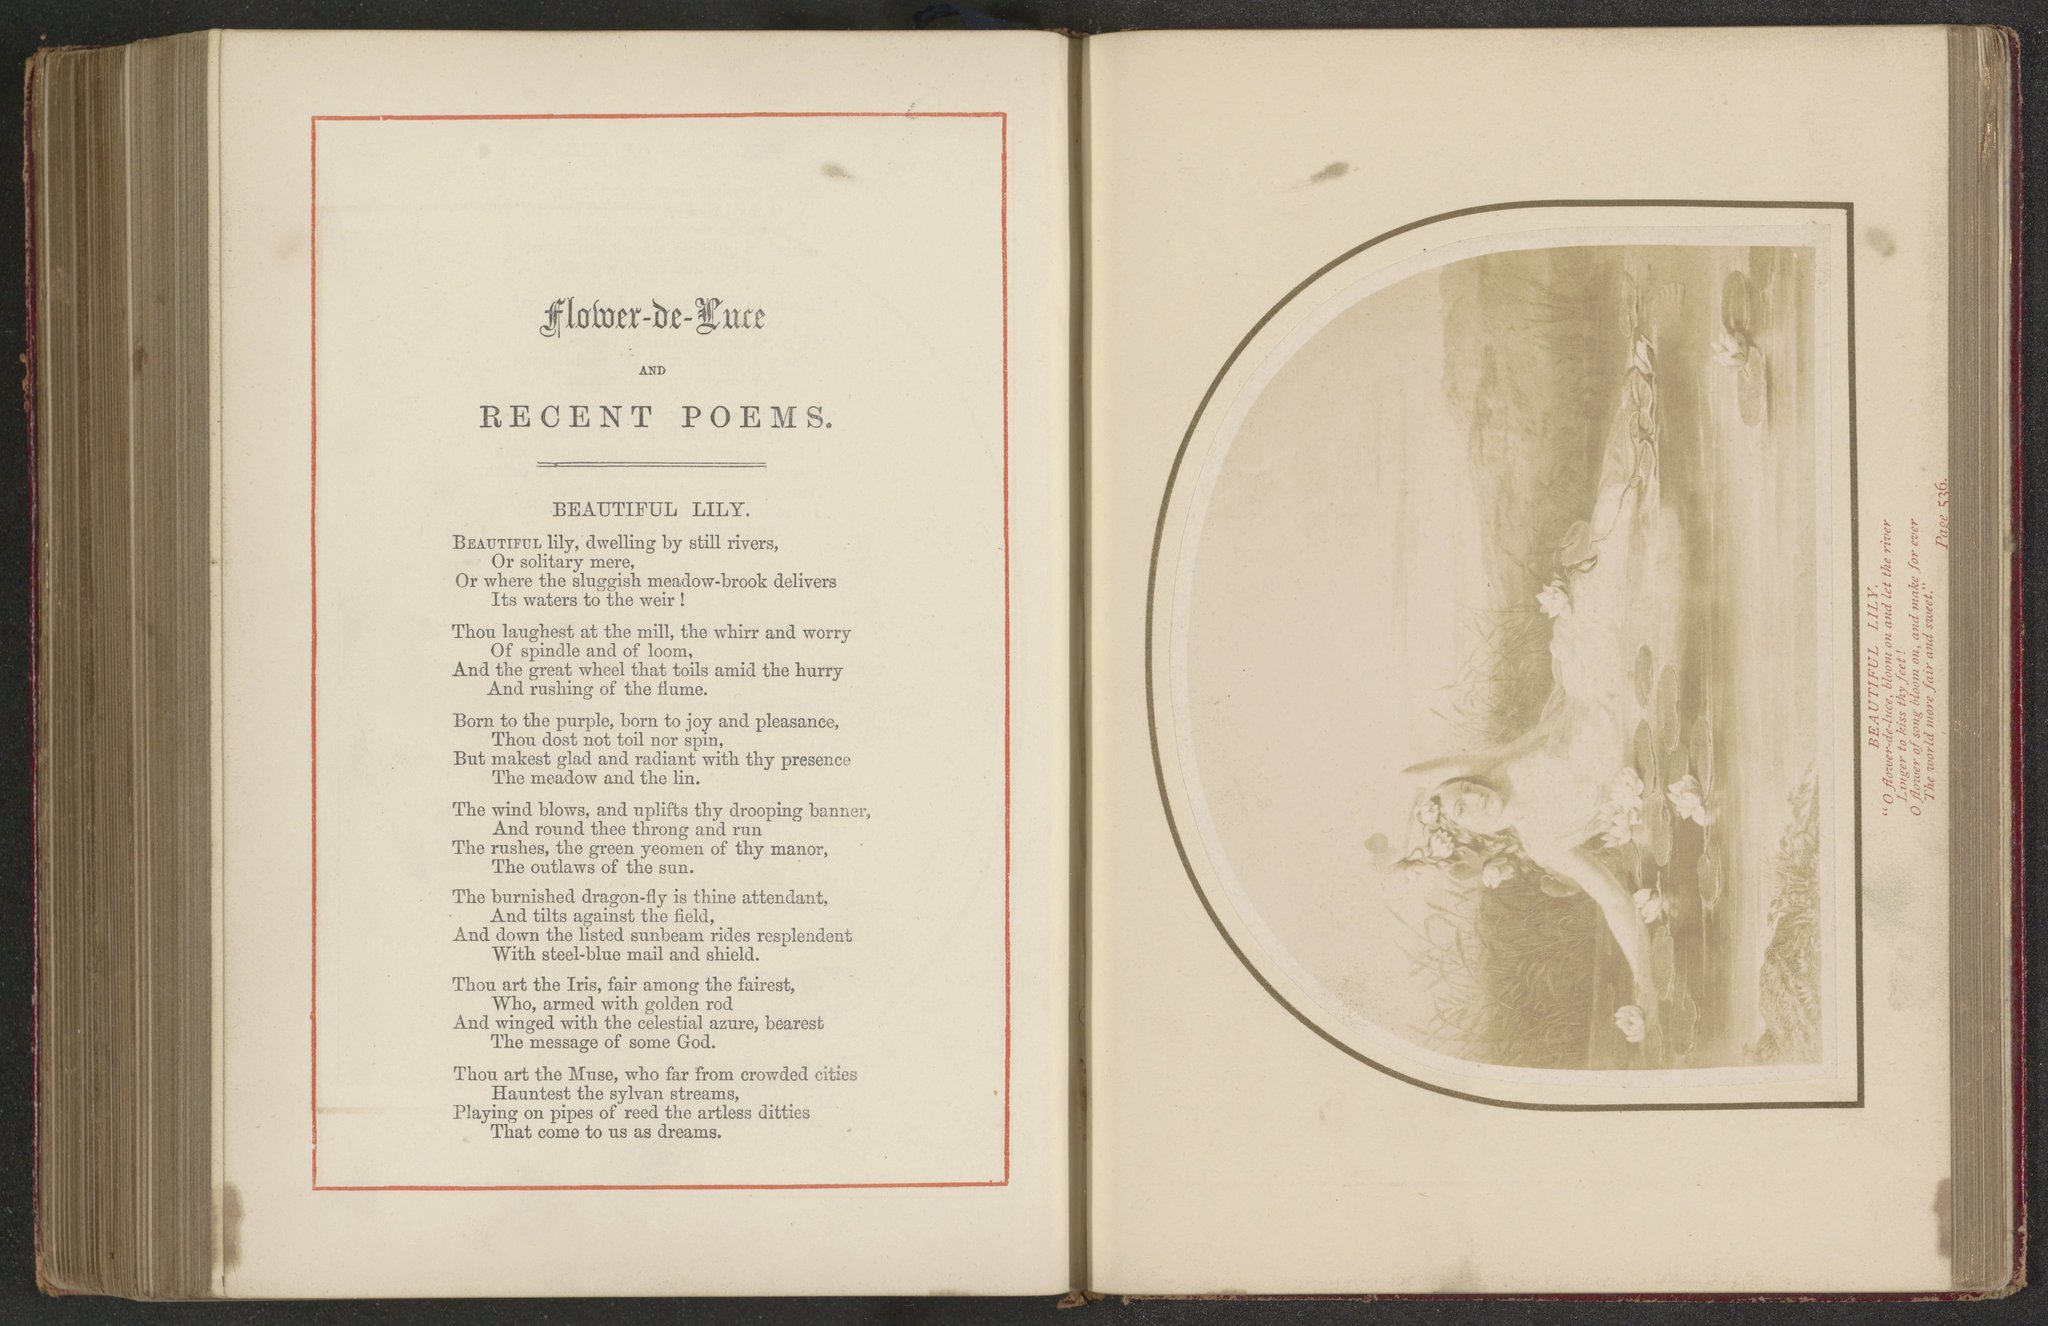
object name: photograph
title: Beautiful Lily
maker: john payne jennings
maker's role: fotograaf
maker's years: 1843-1926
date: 1867-1877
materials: photographic support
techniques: albumen print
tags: flowers: water-lily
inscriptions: inscription: ‘" O flower-de-luce, bloom on and let the river Linger to kiss thy feet! O flower of song bloom on, and make, for ever The world more fair and sweet." Page 536.’